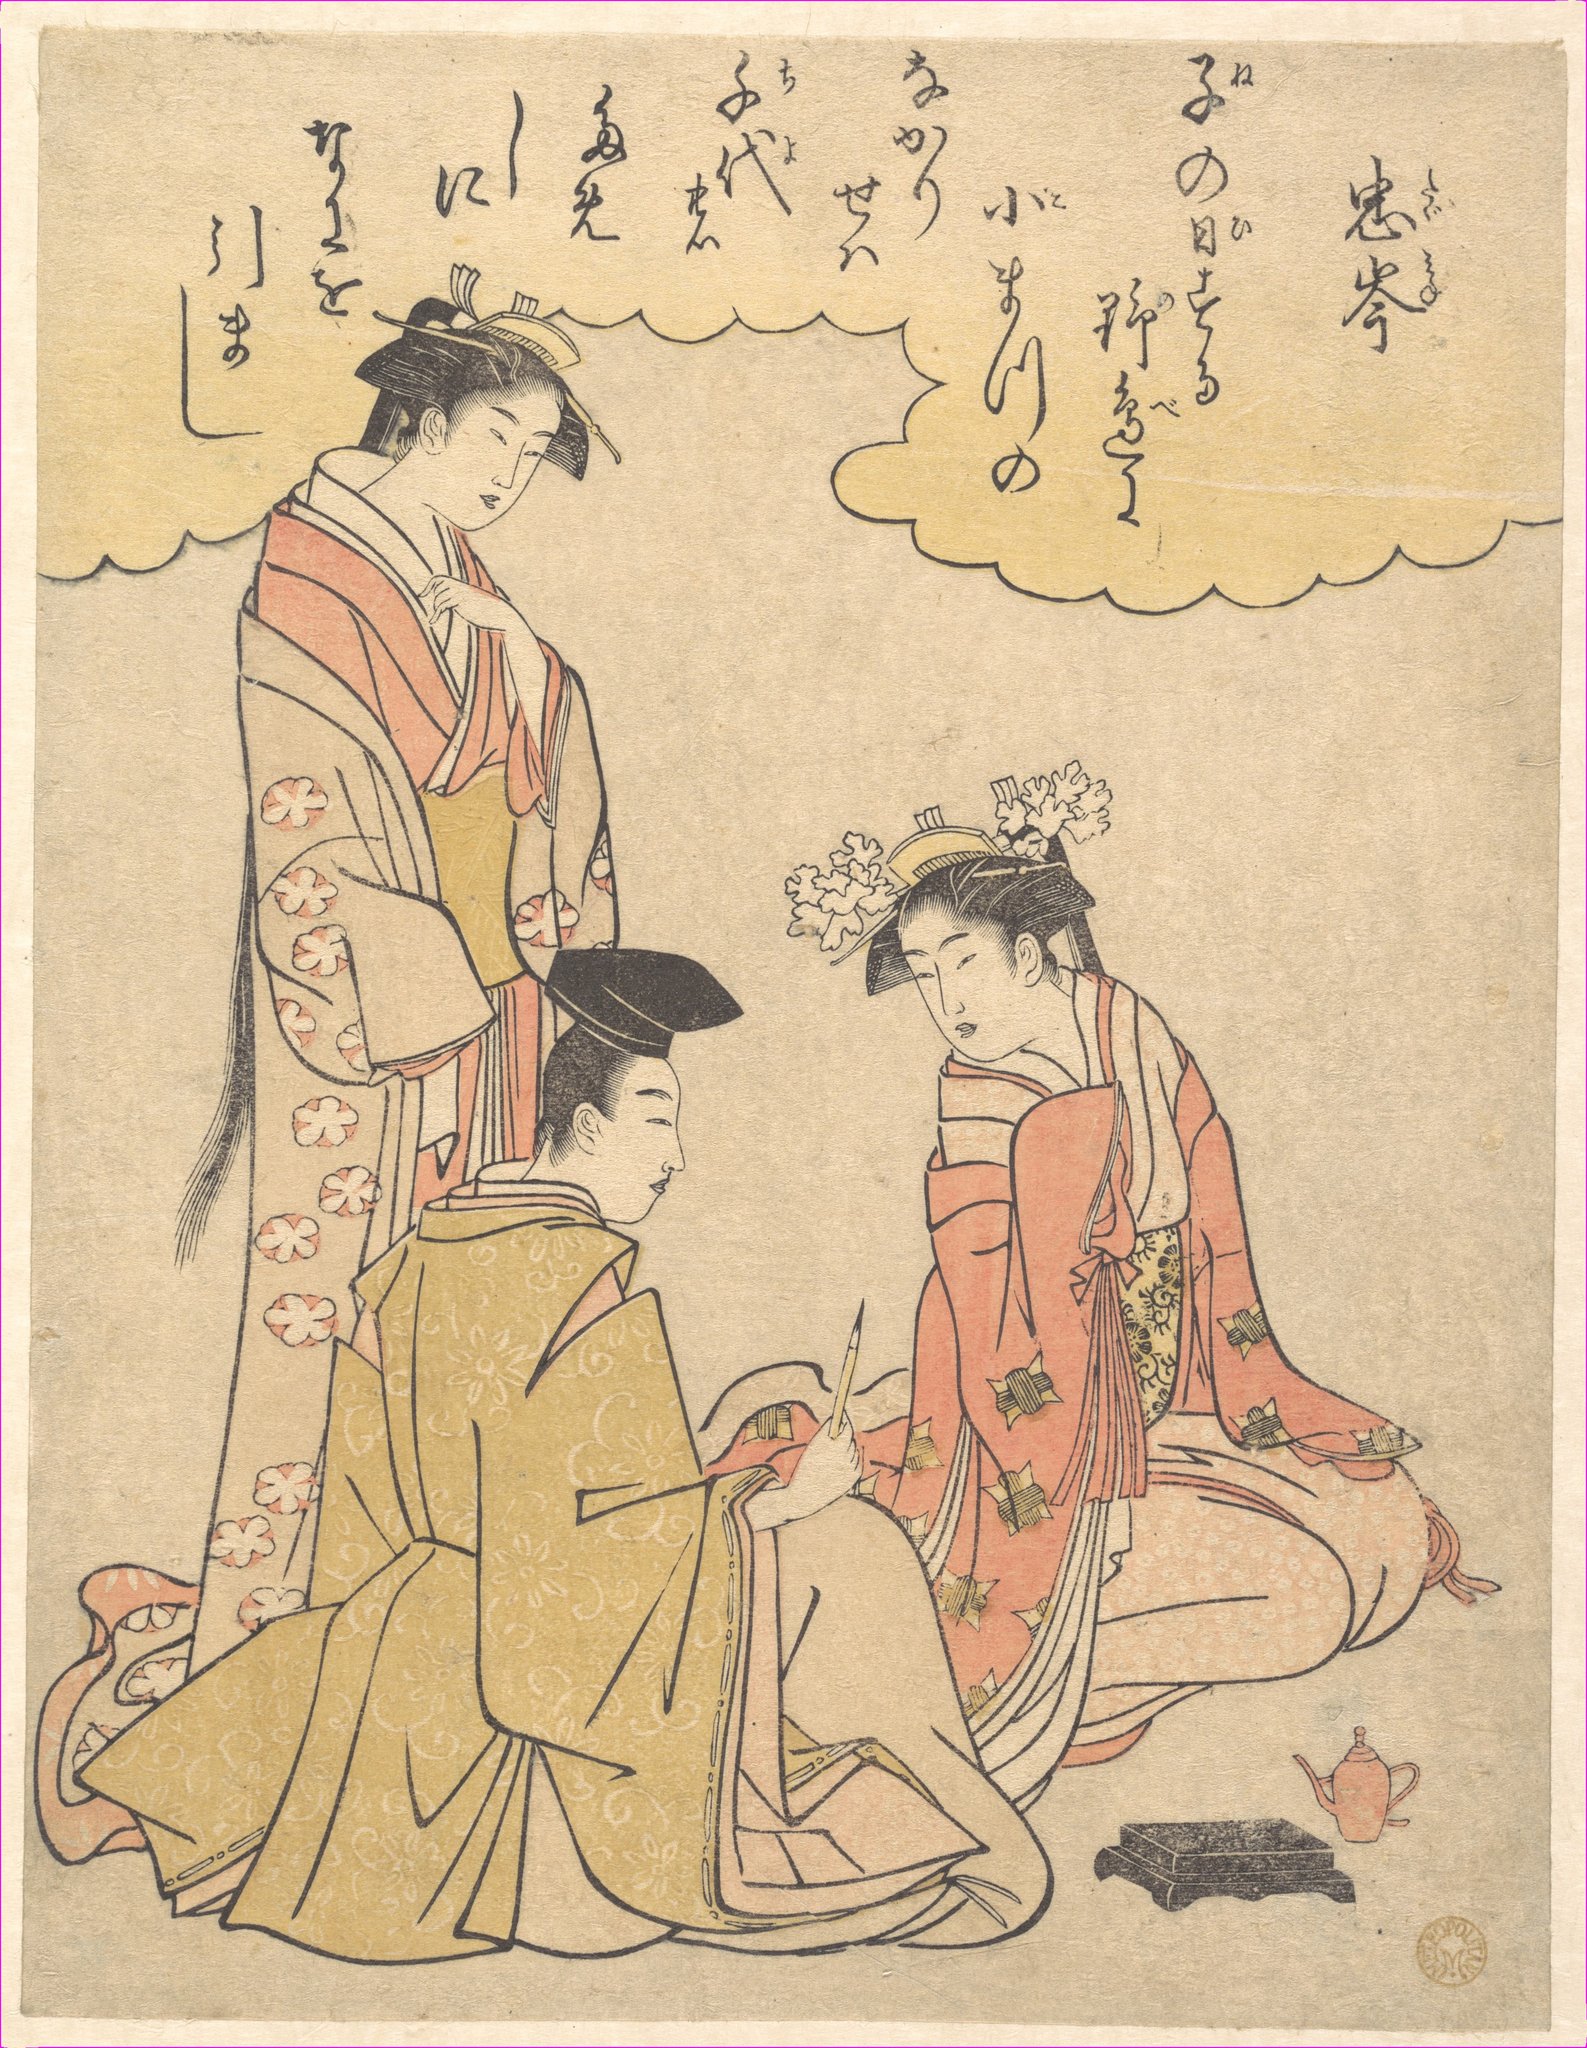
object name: woodblock print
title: Courtier and Two Ladies of the Court, with a Poem by Mibu no Tadamine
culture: japanese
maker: rekisentei eiri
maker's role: artist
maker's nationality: japanese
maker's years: 1789-1801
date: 1791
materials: ink, paper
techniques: woodblock print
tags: men,women,brushes